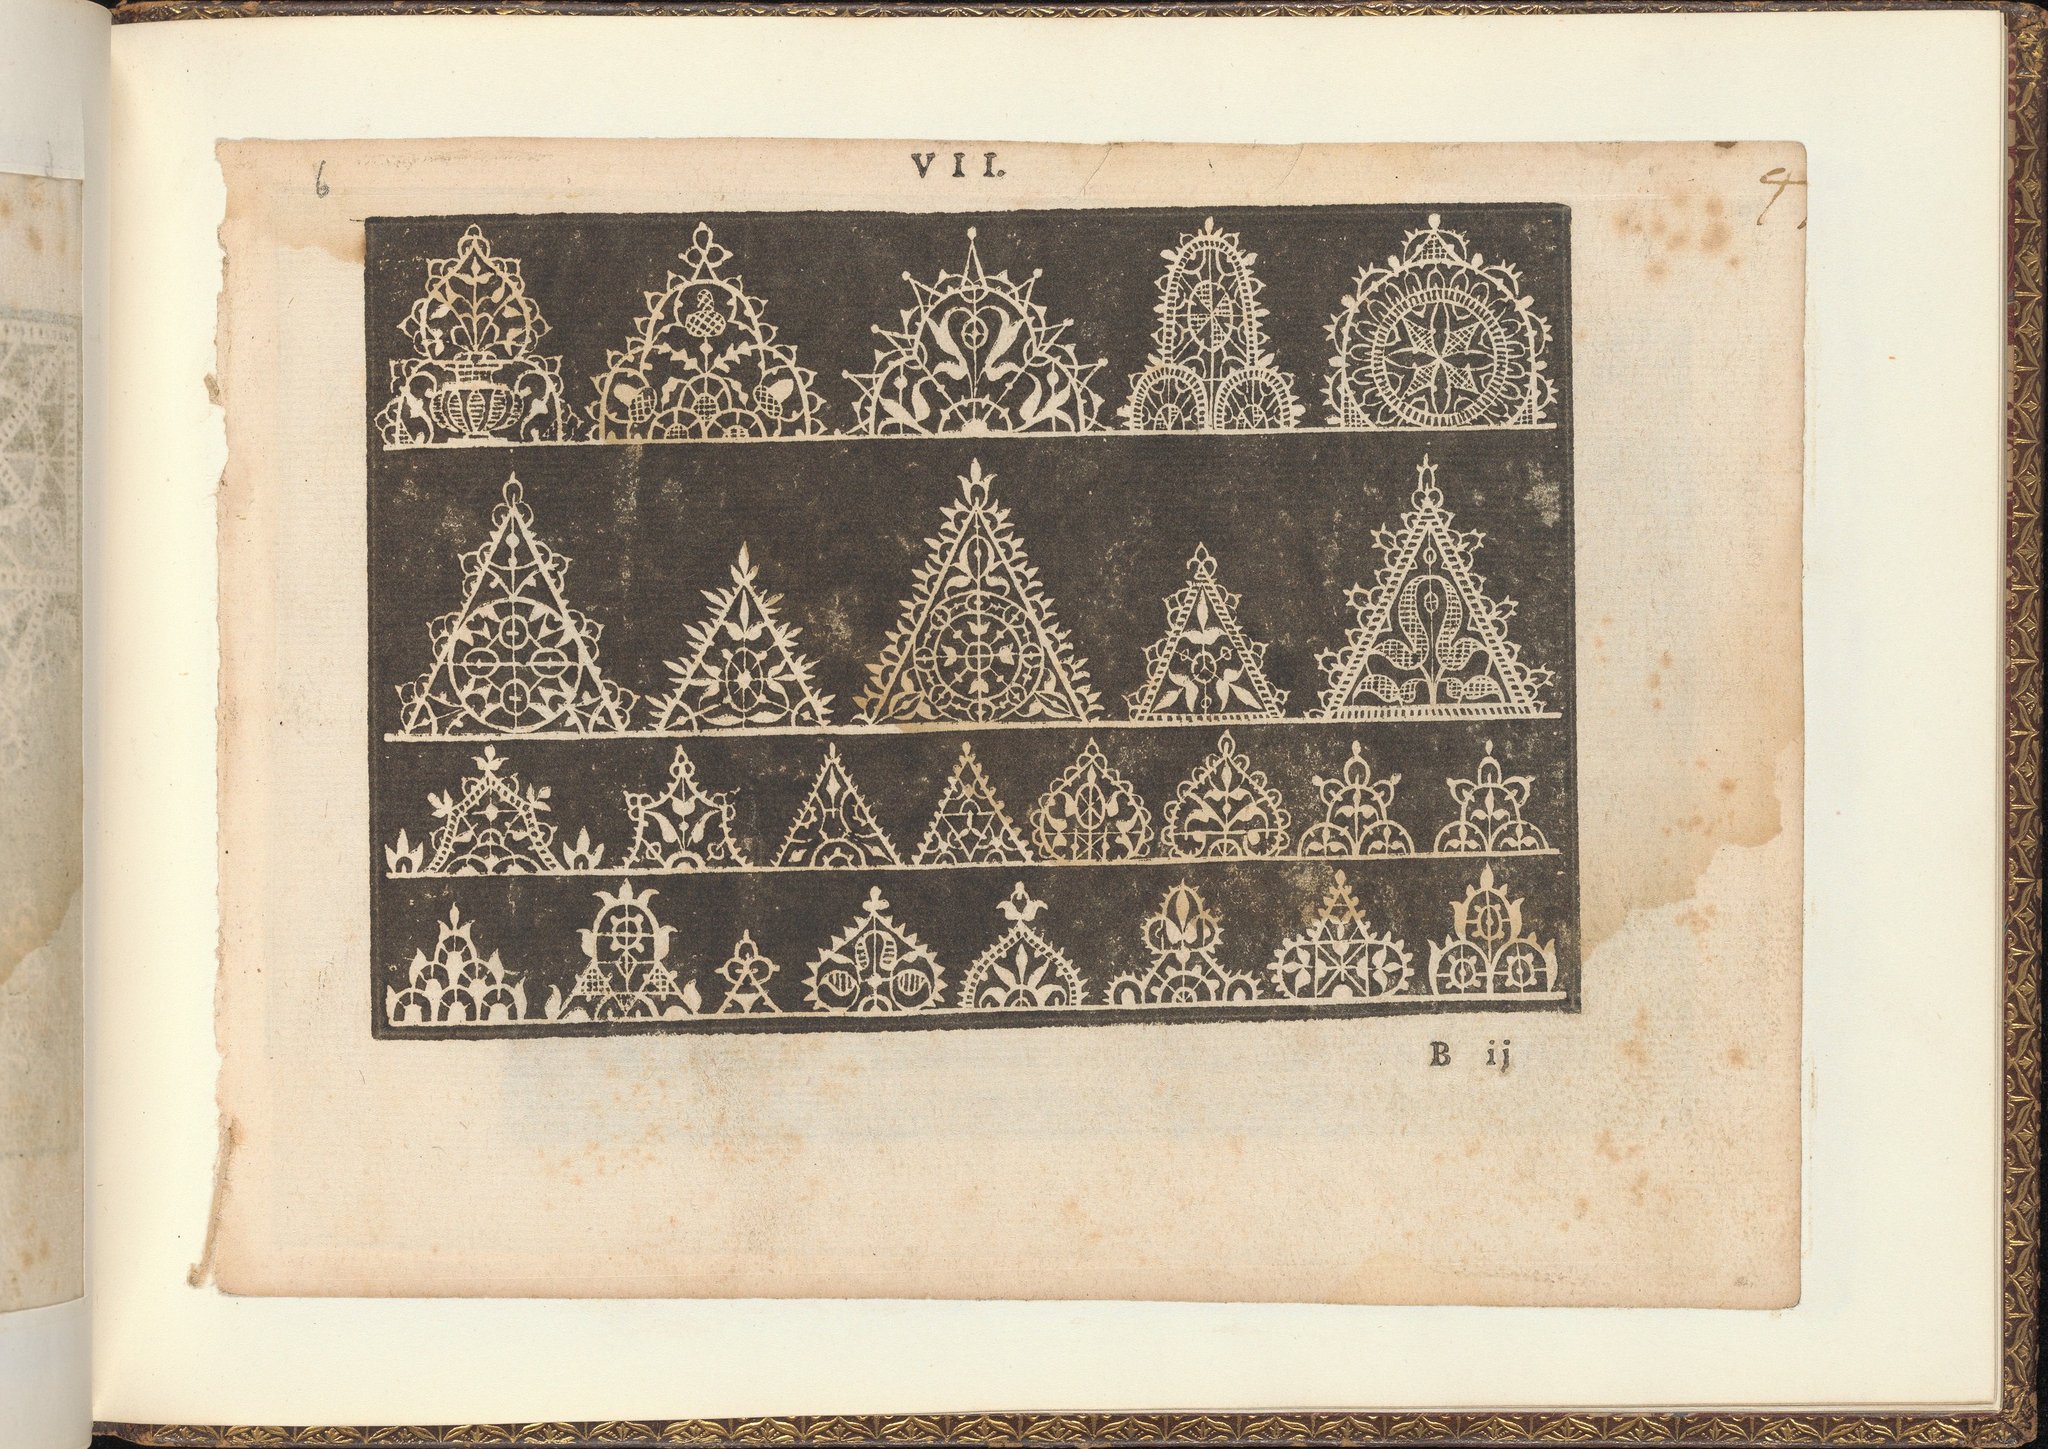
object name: book print ornament architecture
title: Prima parte de' fiori, page 7 (recto)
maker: giovanni battista ciotti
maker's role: author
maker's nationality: italian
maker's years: 1555-1659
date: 1591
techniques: woodcut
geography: italy